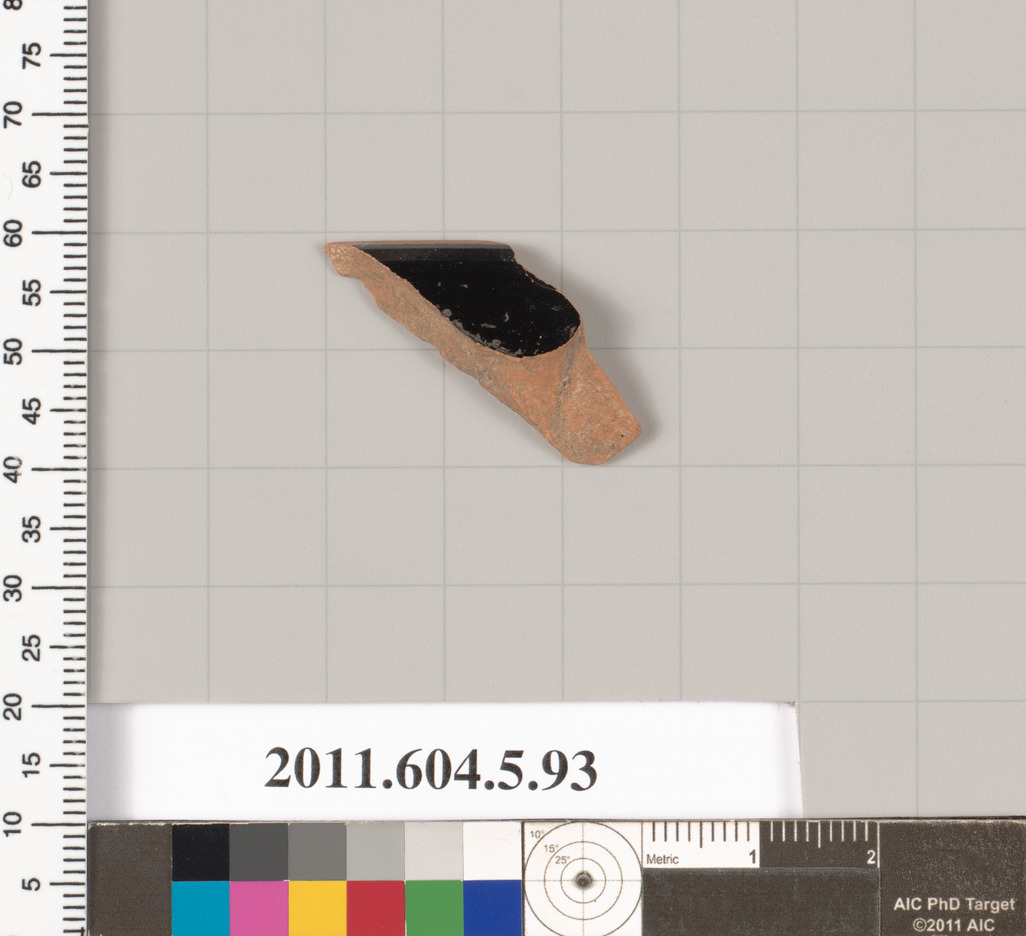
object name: kylix fragment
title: Terracotta rim fragment of a kylix (drinking cup)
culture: greek, attic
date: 475-451 BCE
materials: terracotta